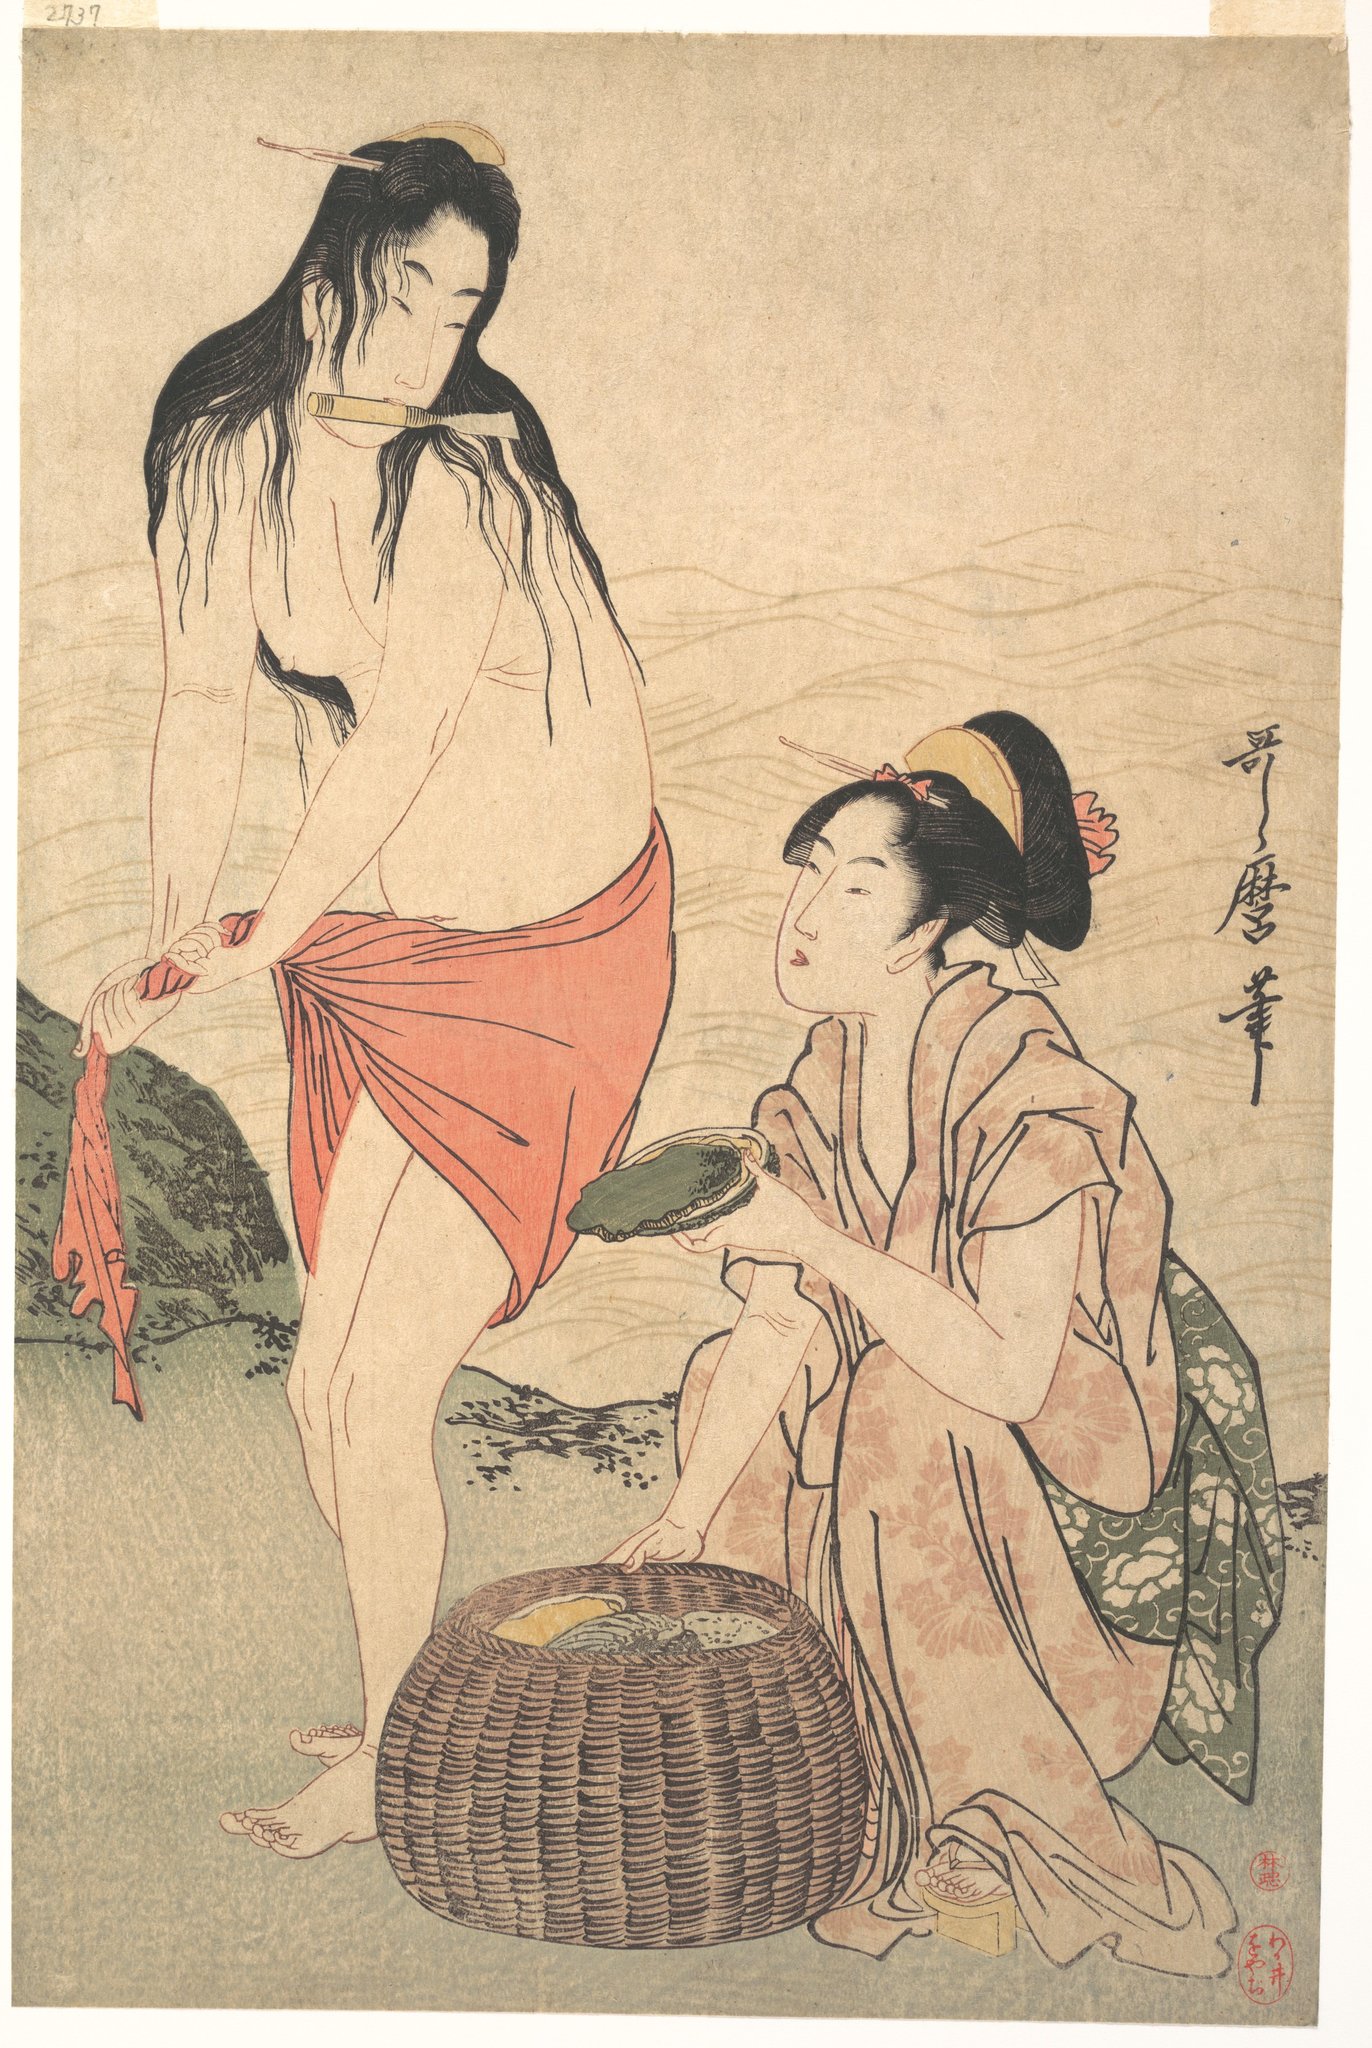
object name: woodblock print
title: Abalone Divers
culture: japanese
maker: kitagawa utamaro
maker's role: artist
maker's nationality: japanese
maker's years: 1754-1806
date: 1788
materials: ink, paper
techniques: woodblock print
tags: women,female nudes